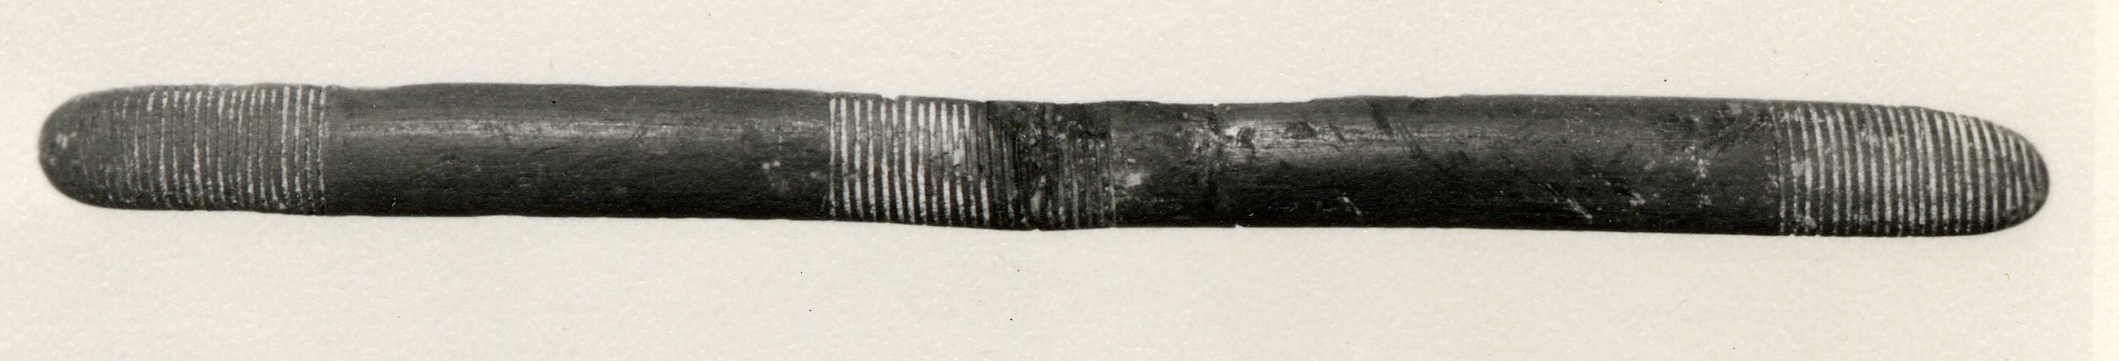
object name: throw stick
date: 1635-1458 BCE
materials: wood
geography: egypt